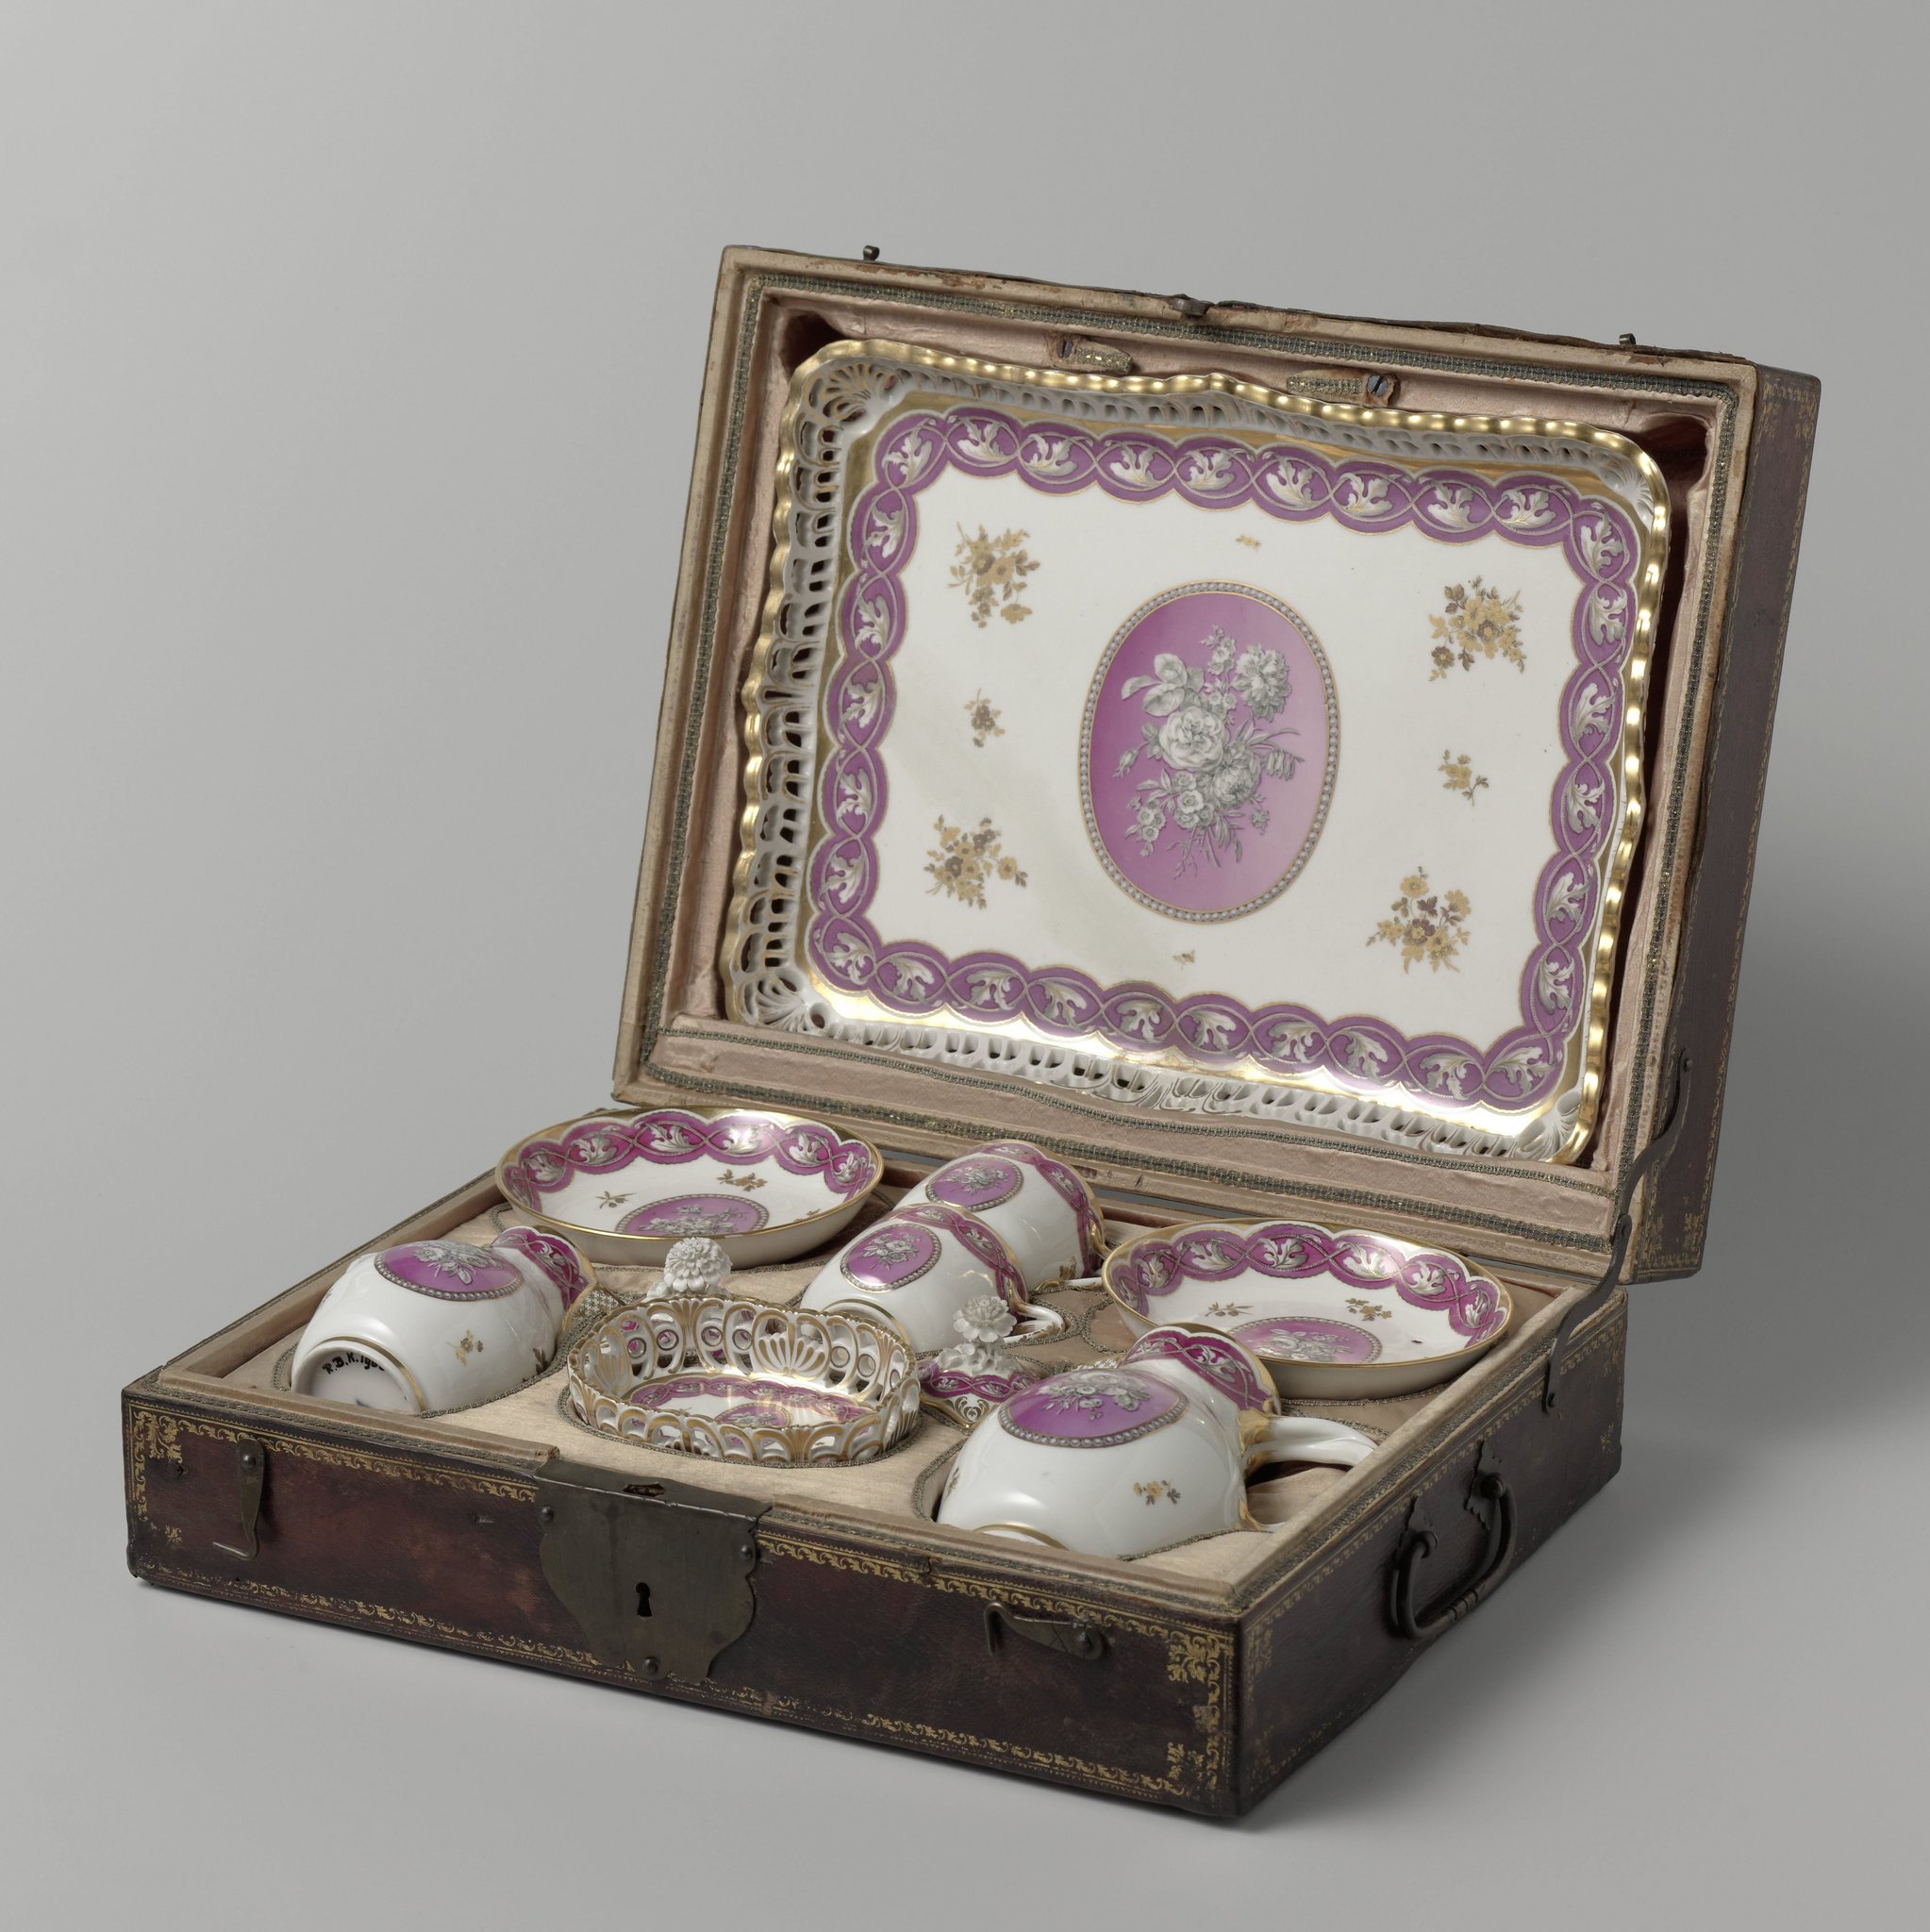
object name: tête à tête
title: Service (tête-à-tête) with a bouquet and foliate scrolls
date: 1775-1778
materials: glaze, gold, leather, paint, porcelain, wood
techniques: embroidery, firing, forming, gilding, turning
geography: vienna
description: Empress Maria Theresa of Austria presented this tea service to the pastellist Jean Etienne Liotard, who had portrayed her eleven children in Vienna. The service was made in the Viennese porcelain factory, which had been established by Claudius Innocentius du Paquier in 1718; for this enterprise, he had lured workers away from Meissen. Maria Theresa took over the factory in 1744 and renamed it the Kaiserliche Porzellanmanufaktur.